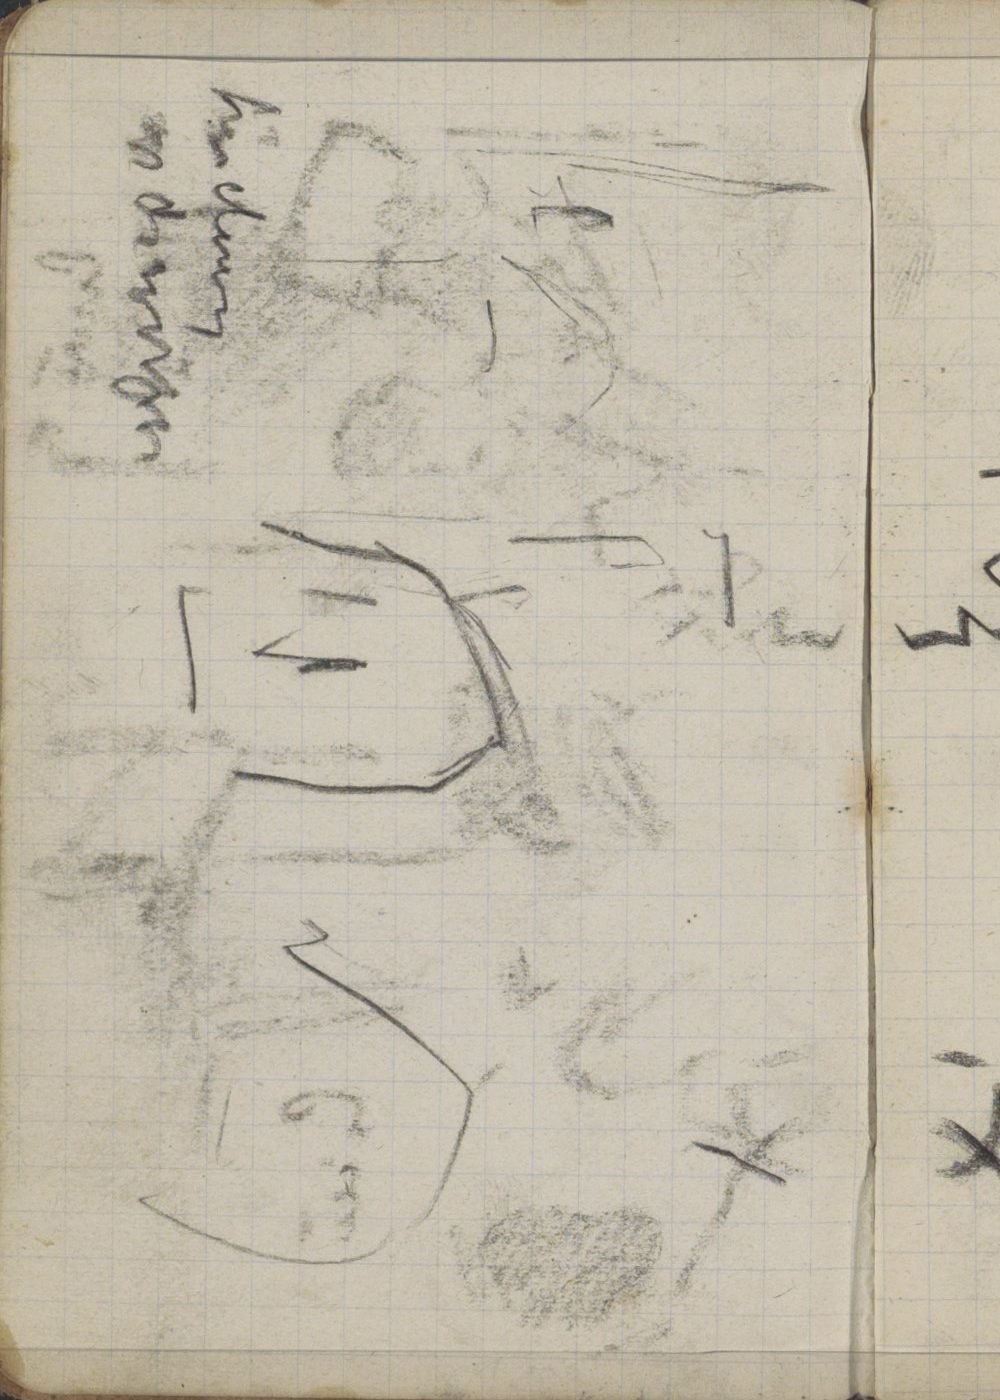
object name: sketchbook leaf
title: Studies en annotaties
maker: george hendrik breitner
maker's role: draughtsman, painter, print maker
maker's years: 1857-1923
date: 1893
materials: chalk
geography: amsterdam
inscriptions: annotation: ‘[...]’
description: Studies en annotaties. Pagina 5 uit een schetsboek met 30 bladen vervaardigd in Amsterdam.